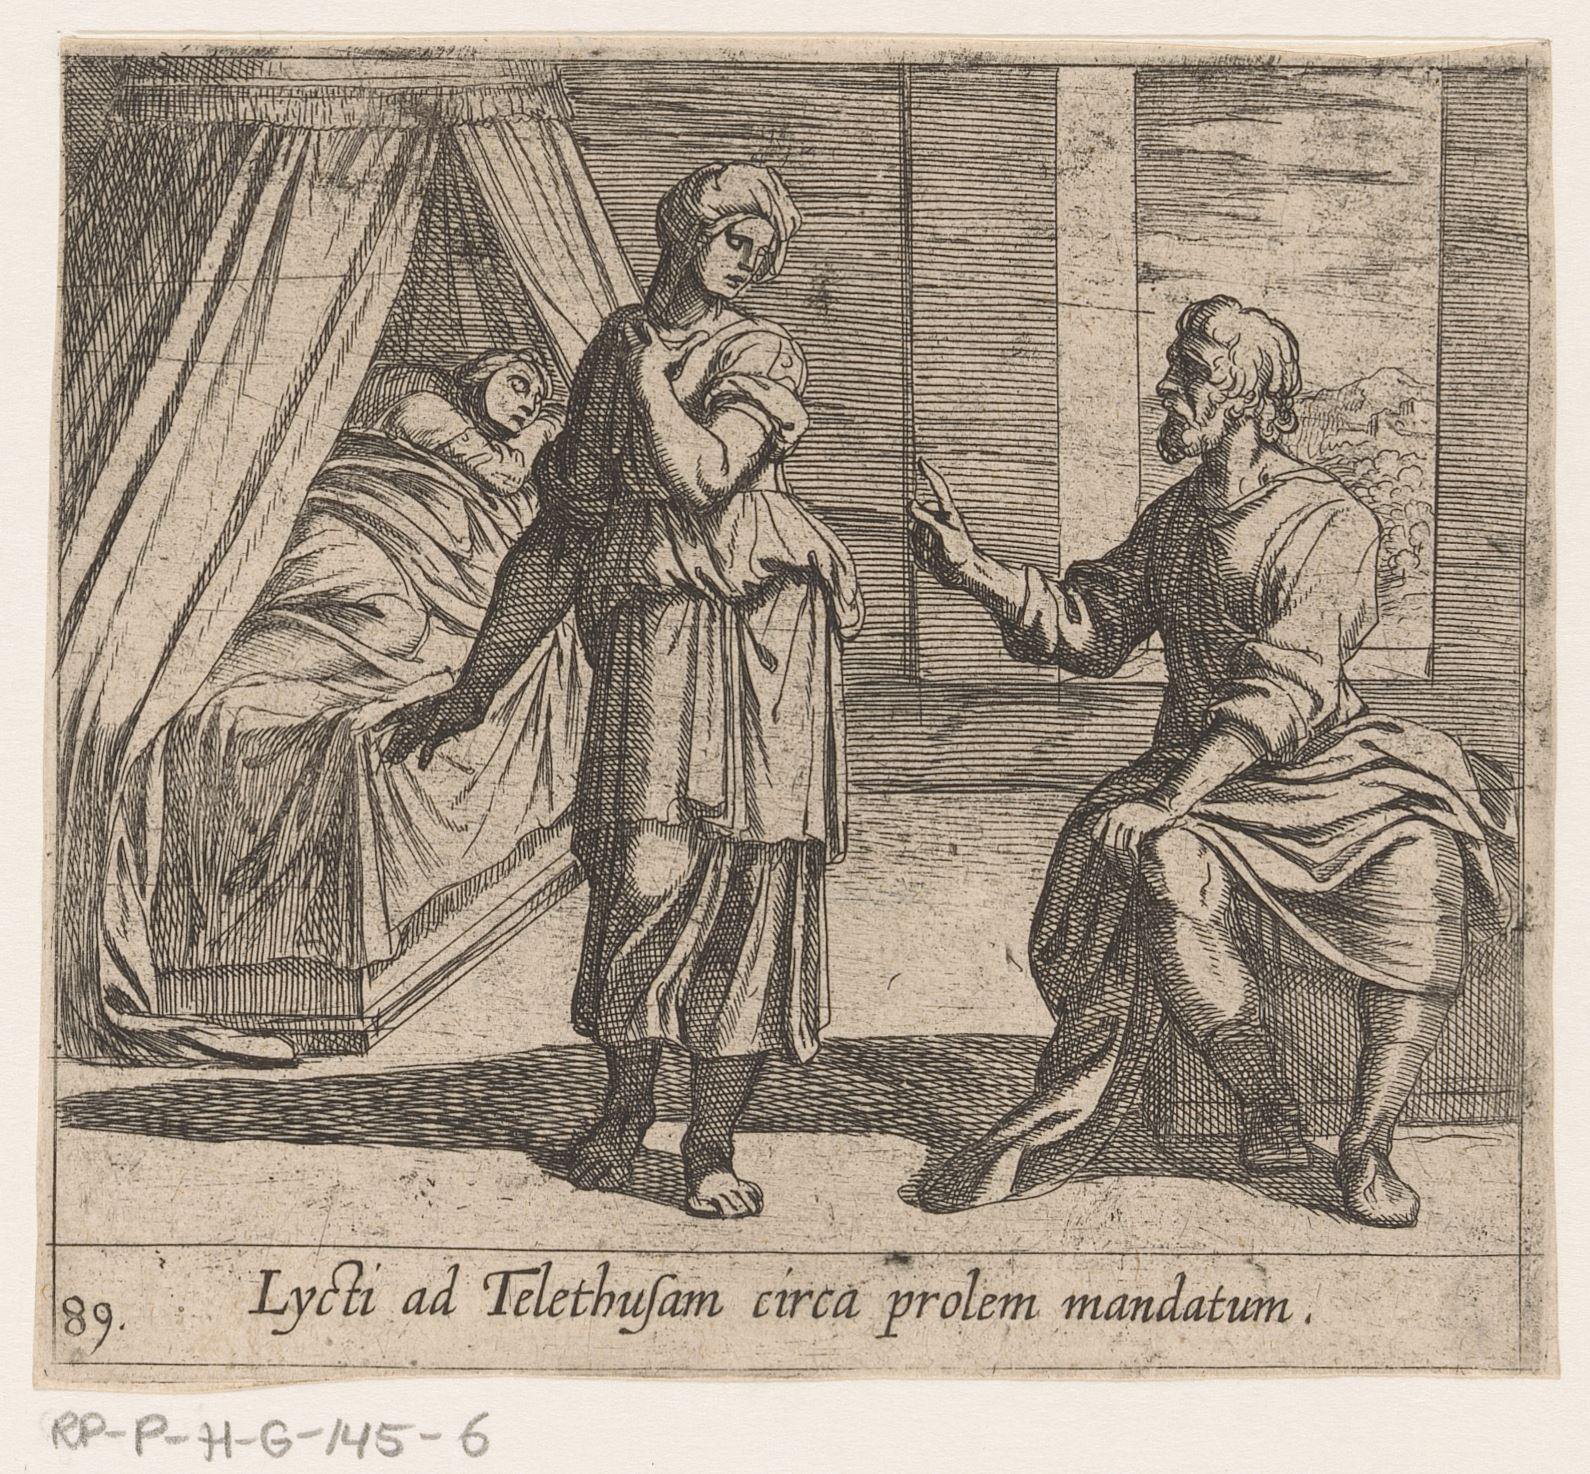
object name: print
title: Ligidus beveelt Telethusa een zoon te baren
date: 1606-1638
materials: paper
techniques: etching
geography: italy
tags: birth of iphis, daughter of ligdus and telethusa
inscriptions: collector's mark: ‘Hinloopen’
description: Deze prent maakt deel uit van een reeks van 150 prenten (+ titelprent) met voorstellingen van de Metamorfosen van Ovidius.